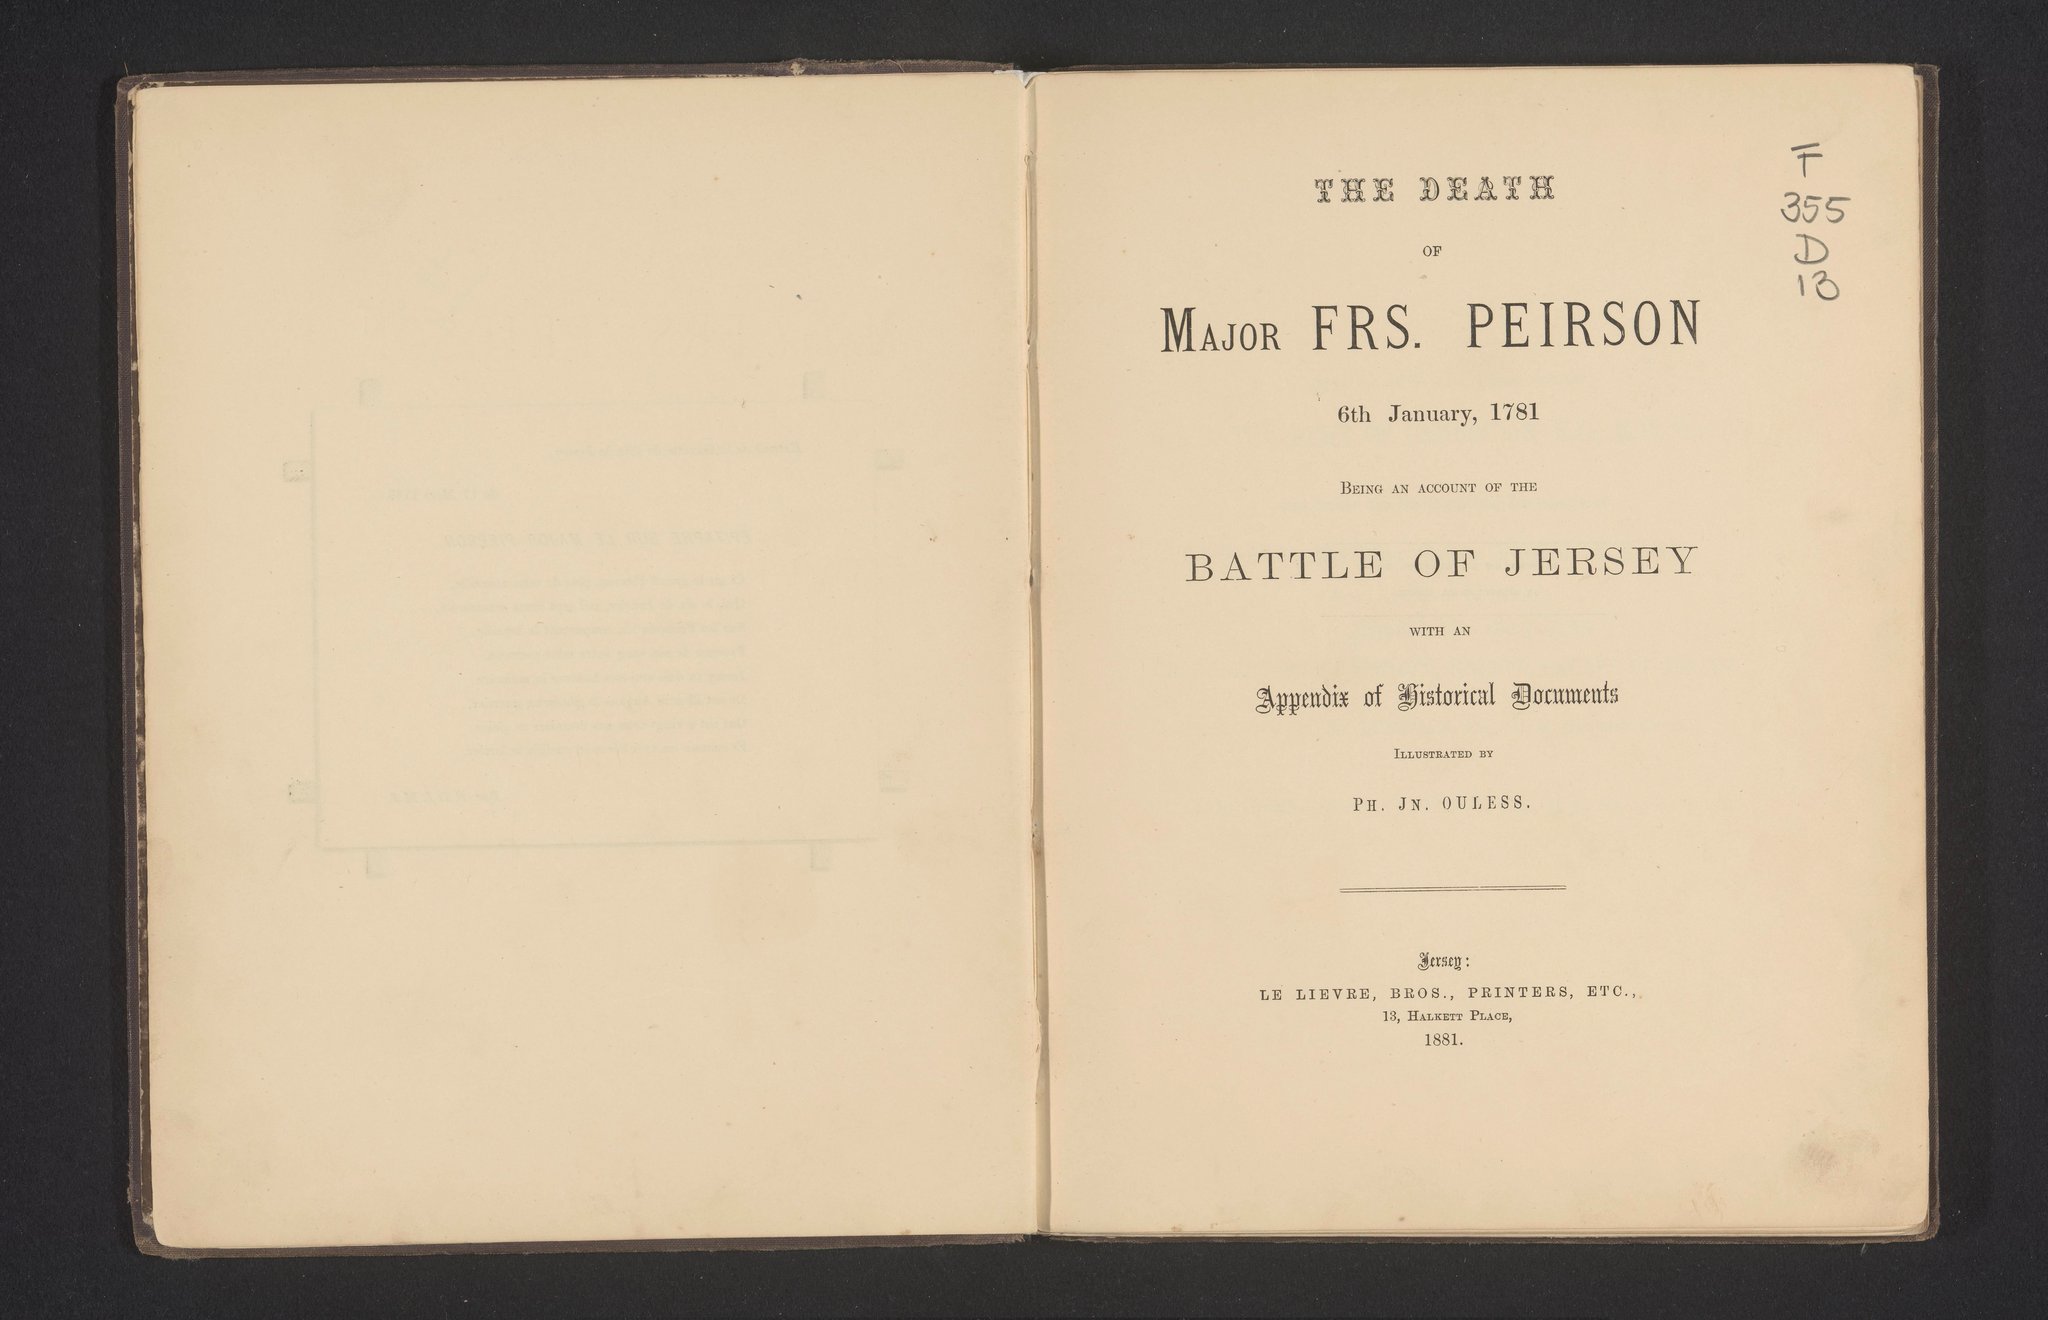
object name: book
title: The death of Major Frs. Peirson 6th January, 1781 being an account of the battle of Jersey with an appendix of historical documents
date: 1881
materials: linen, paper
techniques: woodburytype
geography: jersey